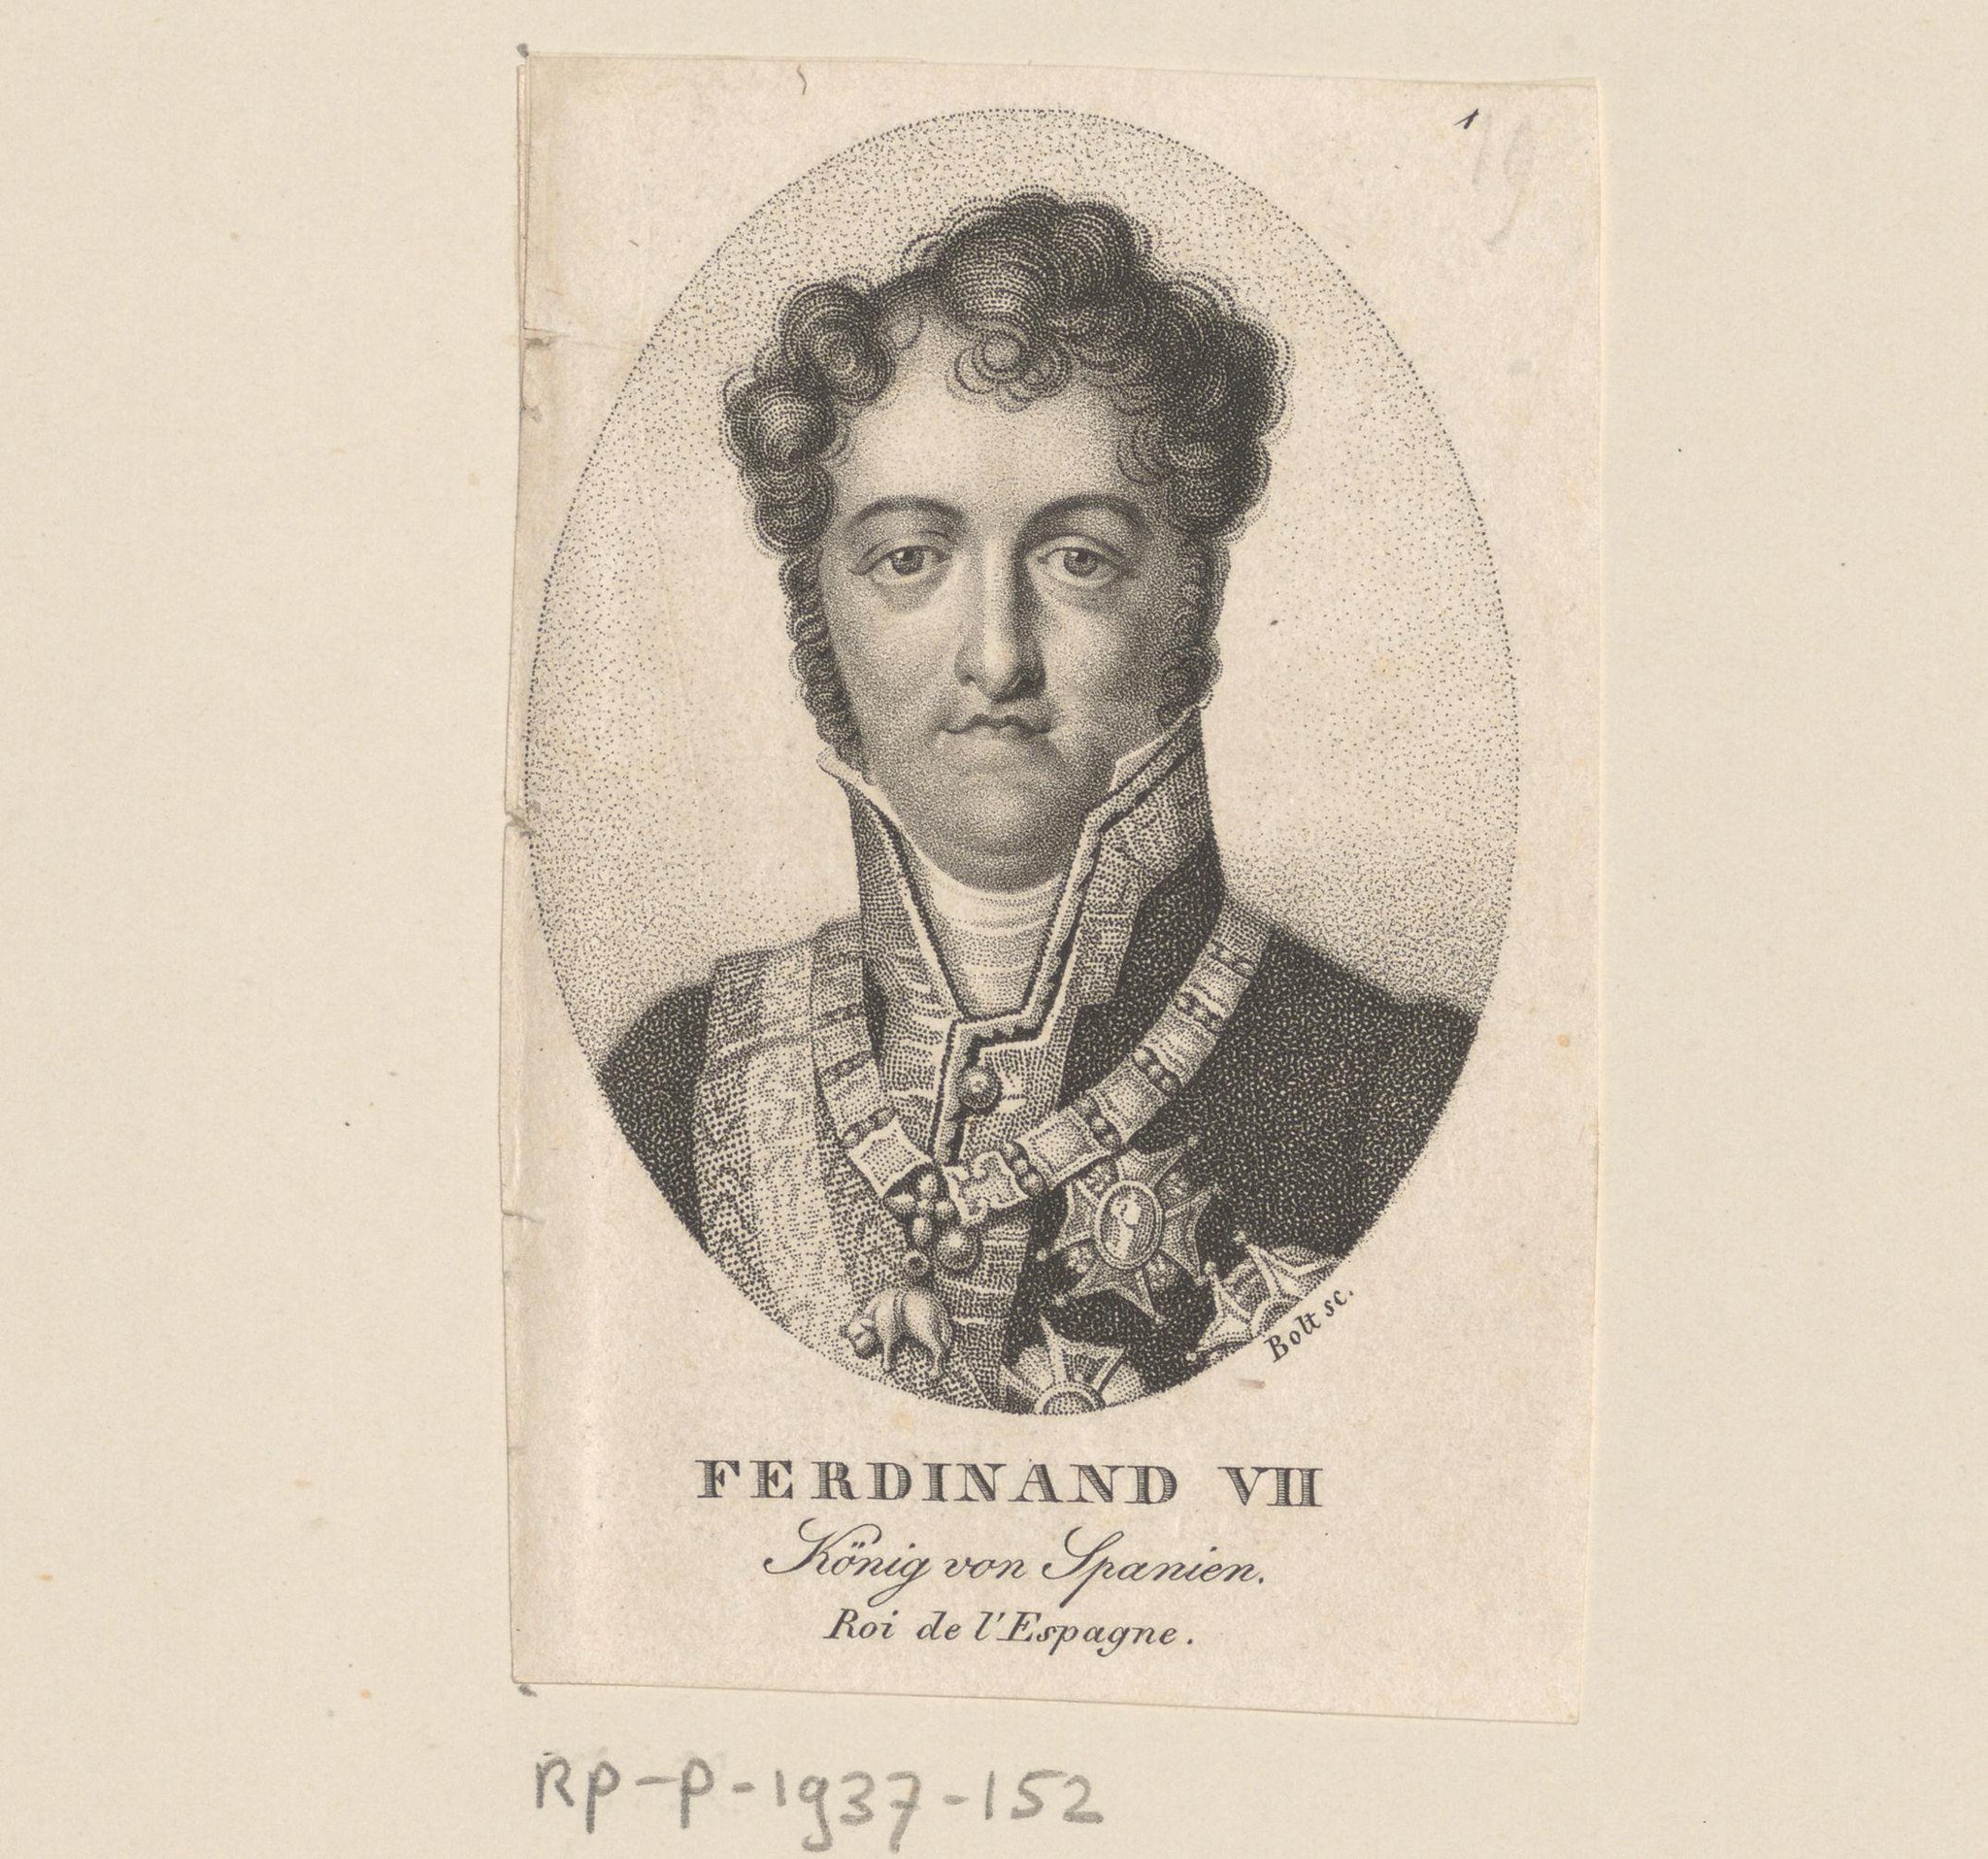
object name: print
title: Portret van Ferdinand VII van Spanje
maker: johann friedrich bolt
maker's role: print maker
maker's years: 1769-1836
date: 1820-1821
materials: paper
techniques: stippling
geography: berlin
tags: ferdinand vii (koning van spanje), historical persons, knighthood order of the golden fleece, king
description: Prent waarschijnlijk uit: Almanach de Gotha pour l'Année 1821. Gotha: Justus Perthes, 1821.